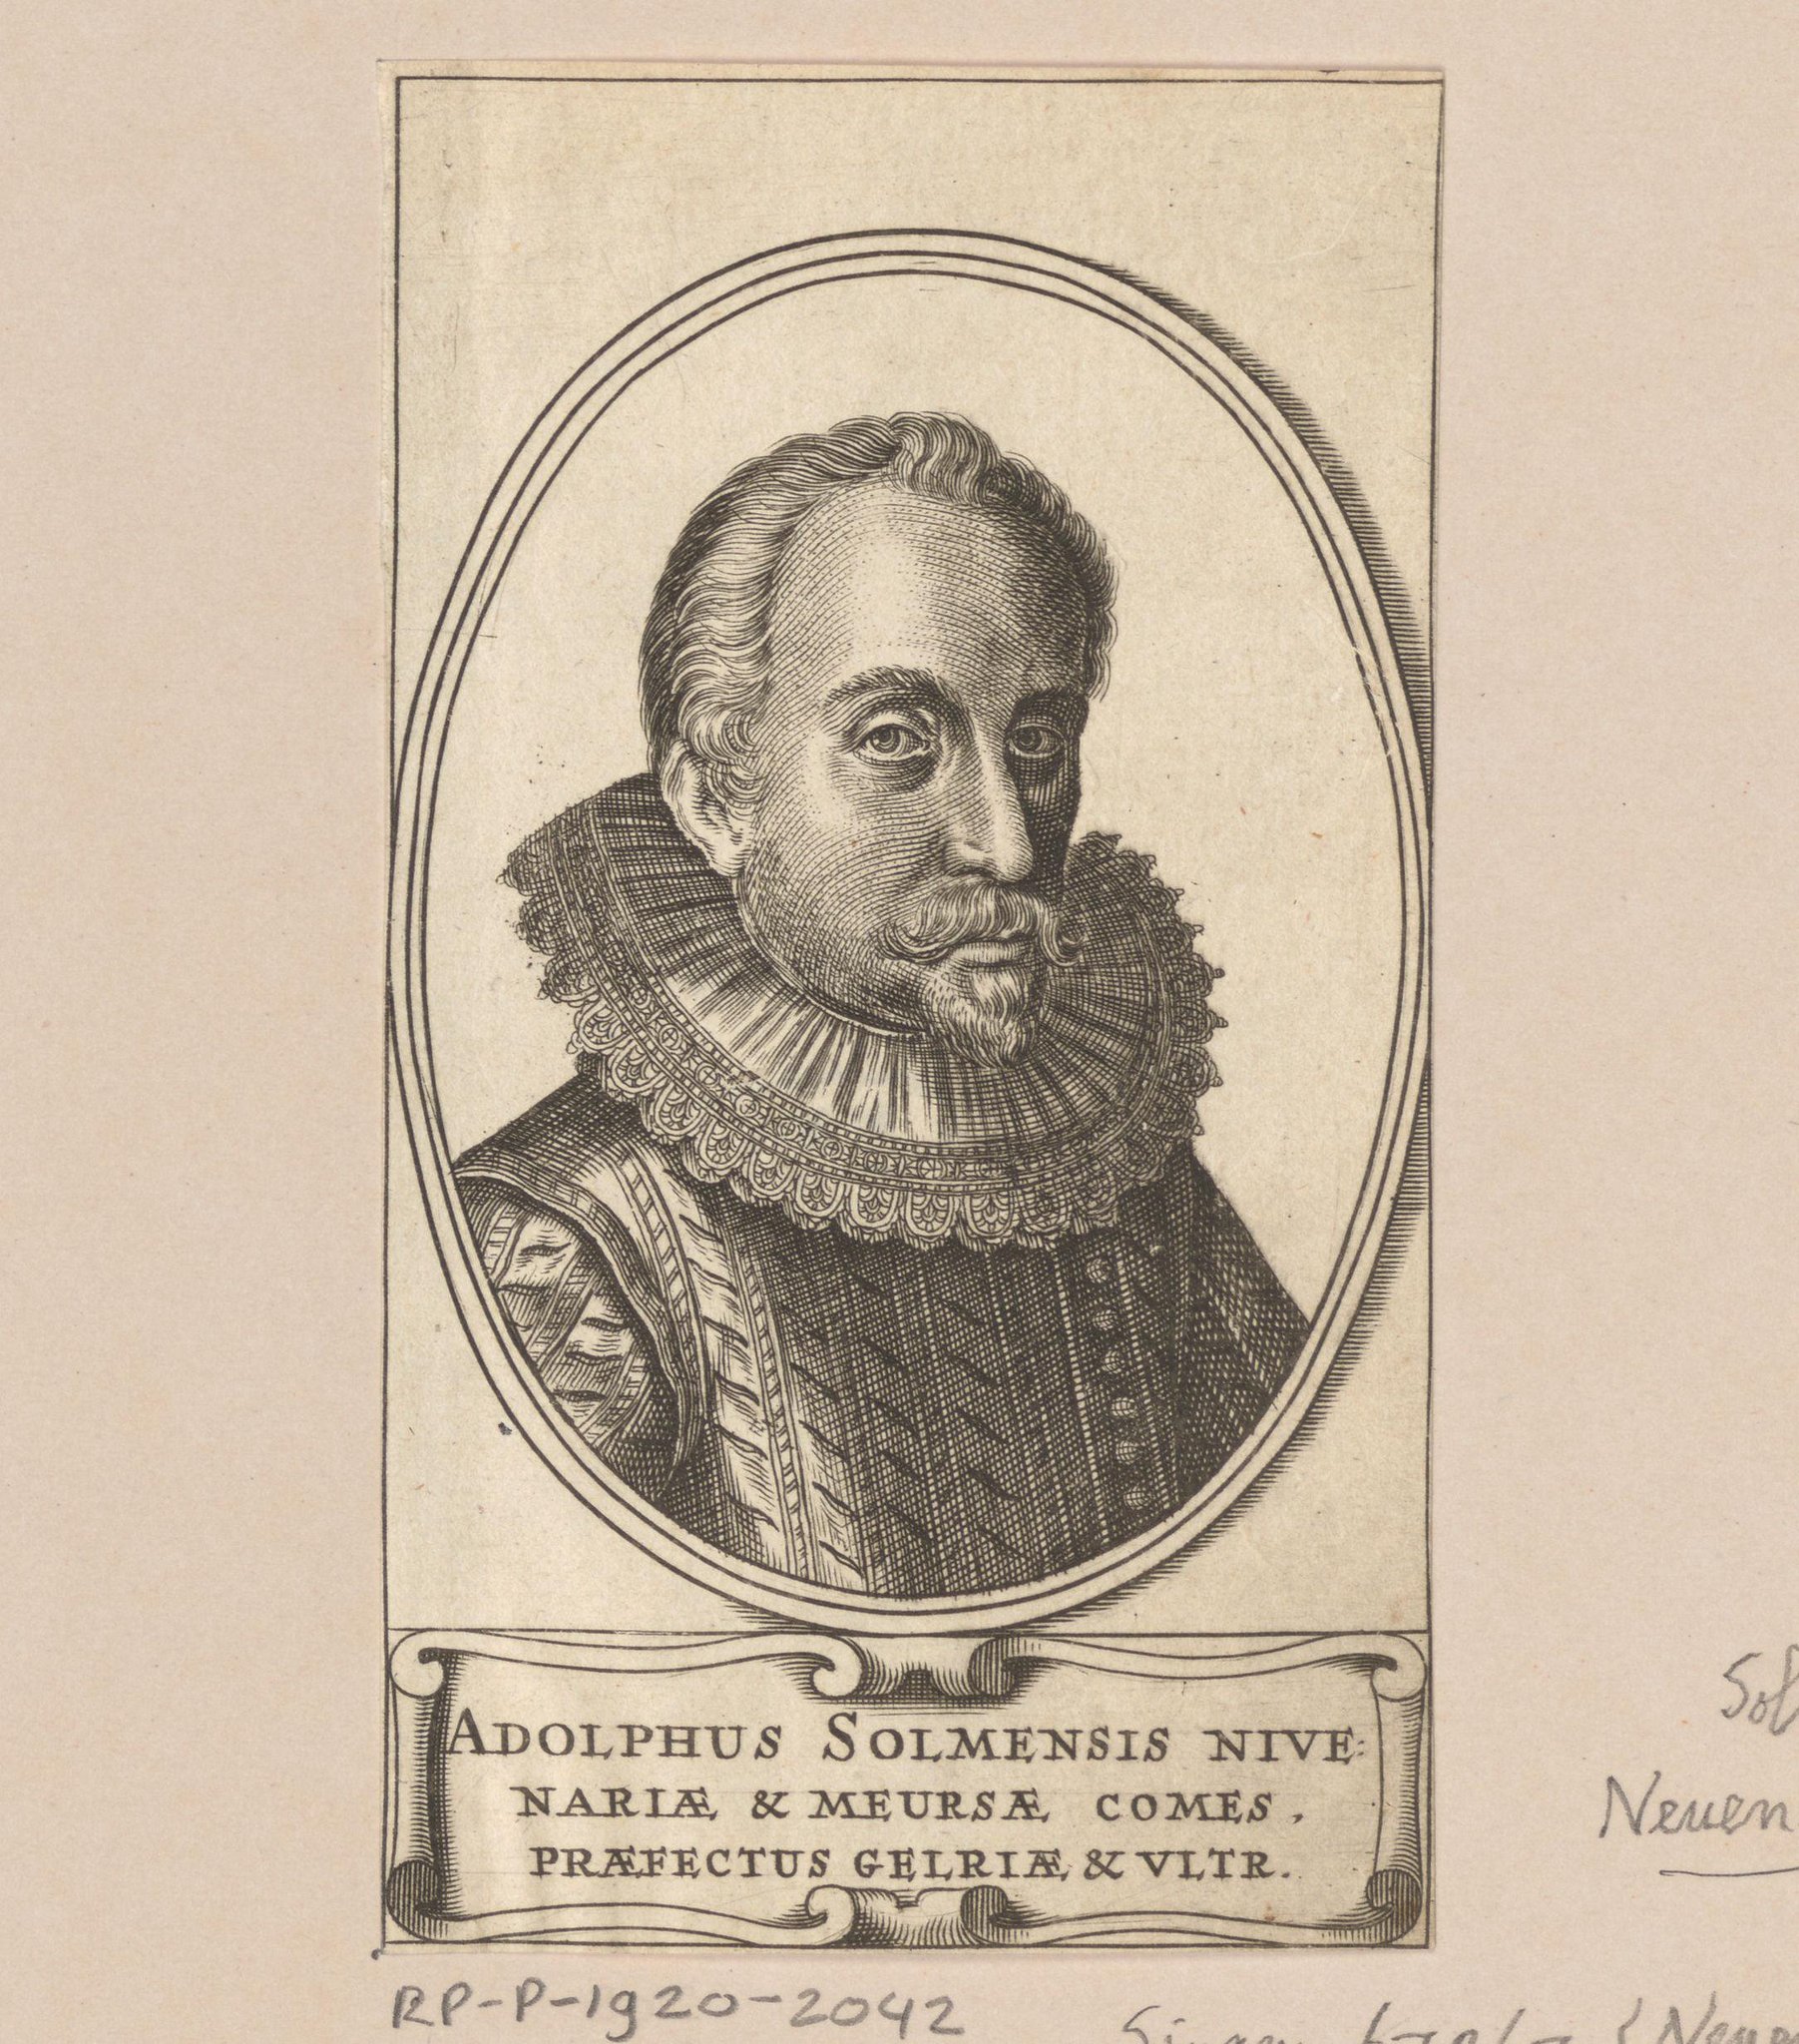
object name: print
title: Portret van Adolf, graaf van Nieuwenaar en Meurs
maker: Anonymous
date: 1658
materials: paper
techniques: engraving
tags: arnhem, commander-in-chief, general, marshal, historical persons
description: Prent mogelijk uit: Strada, Famiana. De bello Belgico decas secunda (...). Rome: Francesco Corbelletti, 1658.